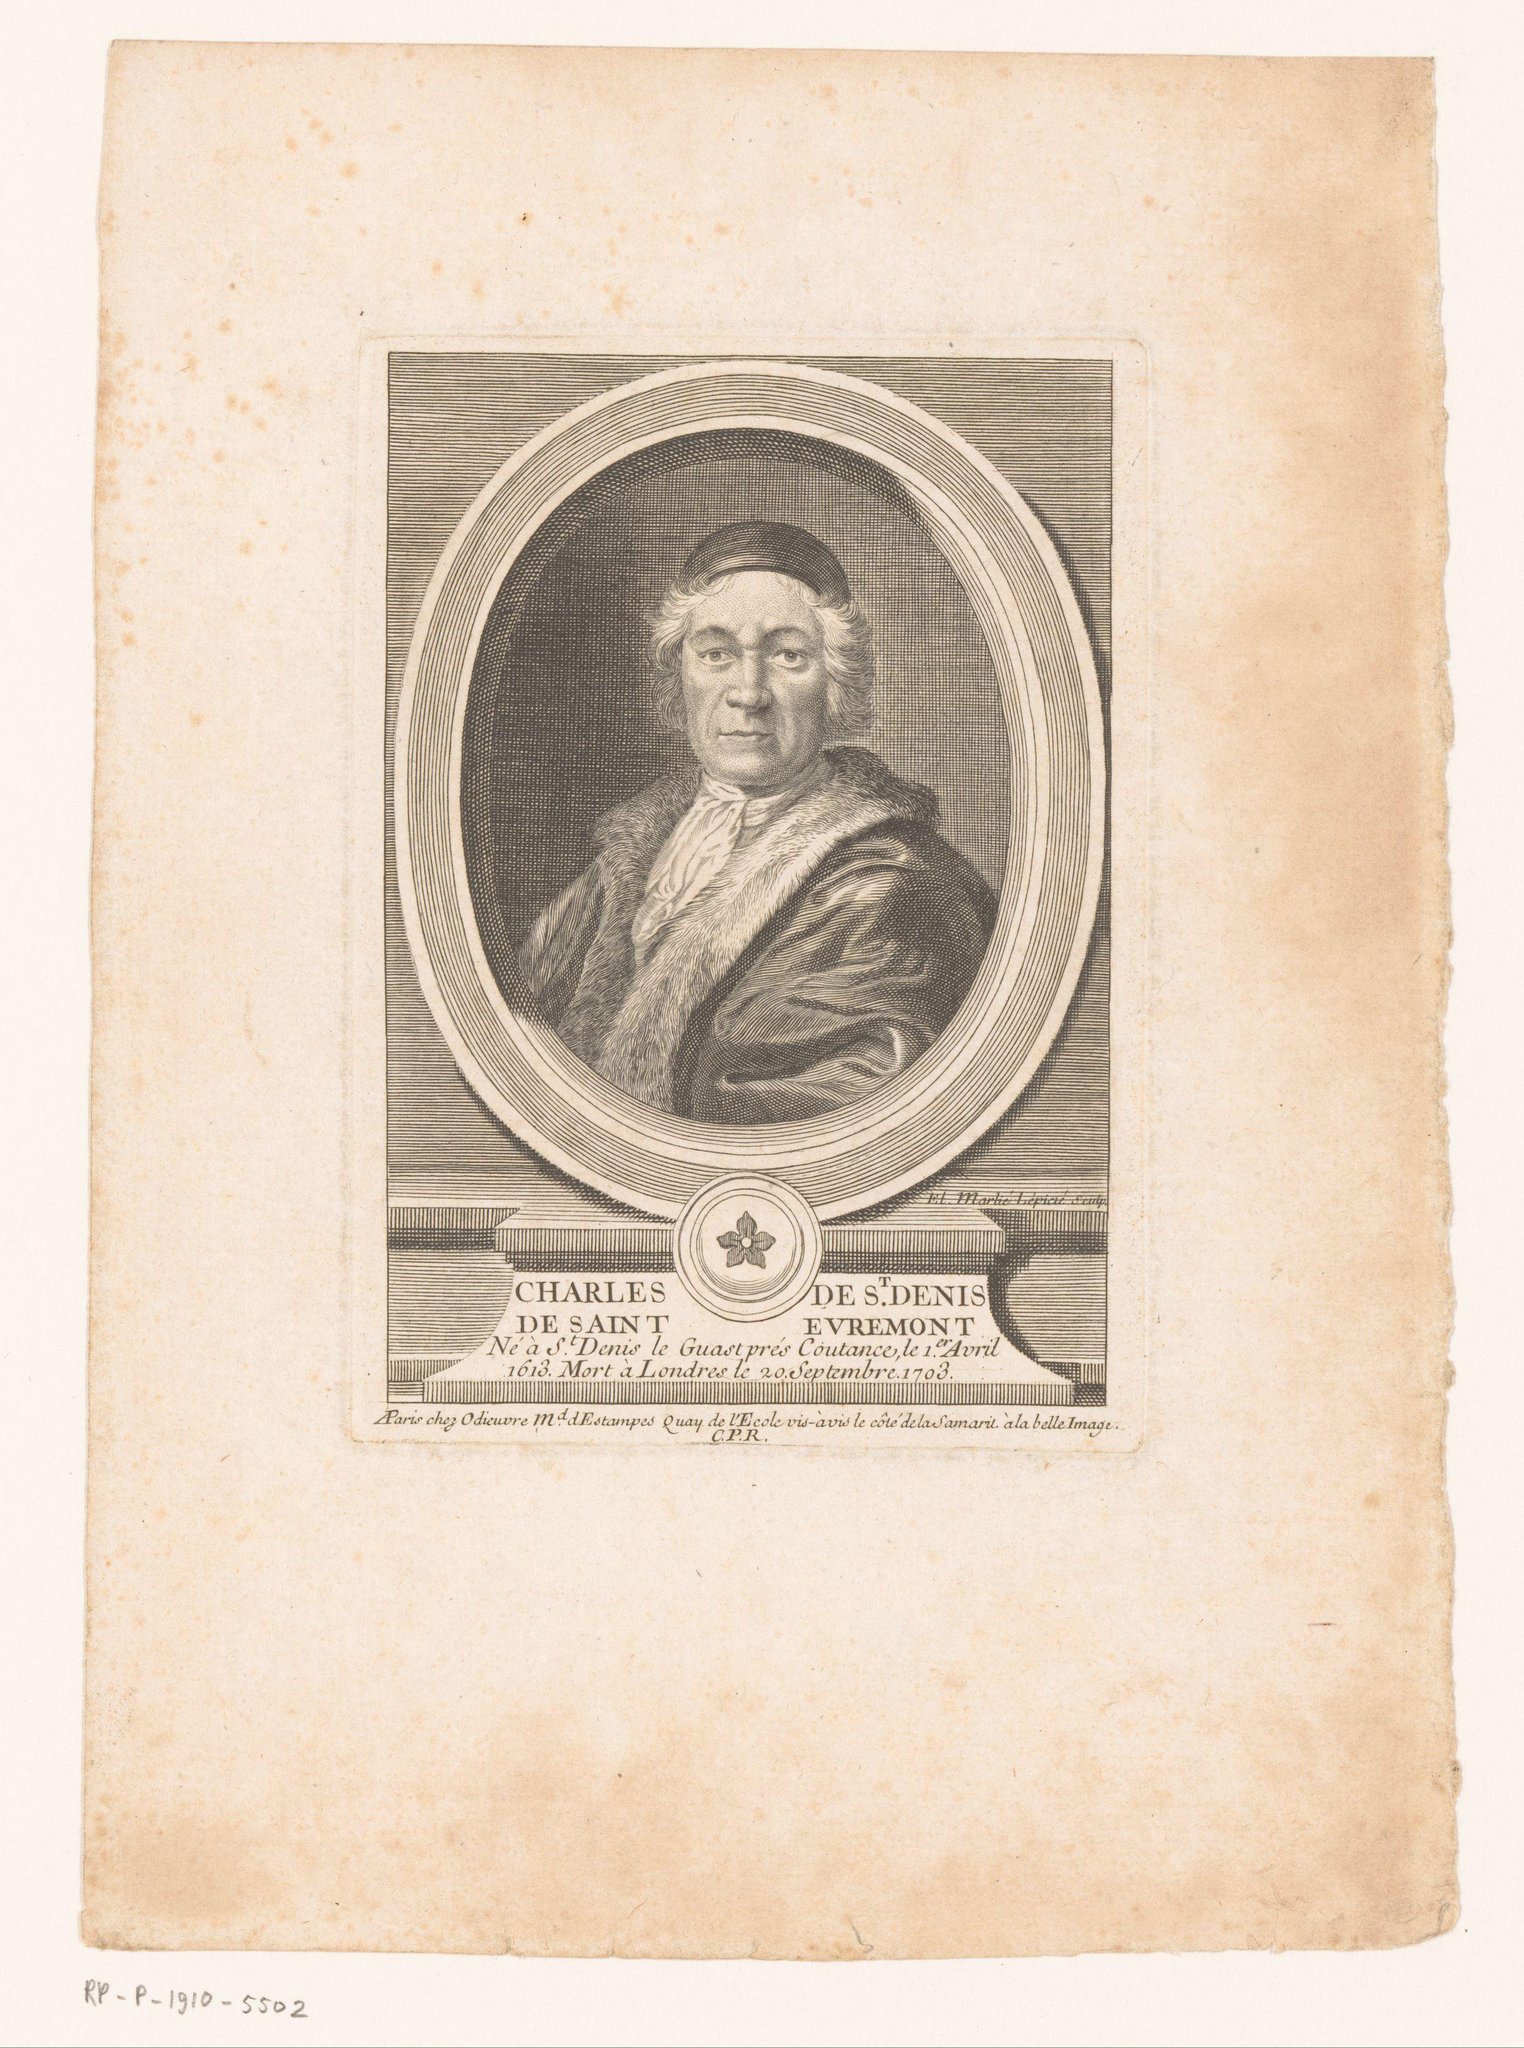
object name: print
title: Portret van Charles de Saint-Évremond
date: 1724-1756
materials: paper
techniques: engraving, etching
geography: france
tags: historical persons, portrait of a writer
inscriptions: collector's mark: Lugt 2228